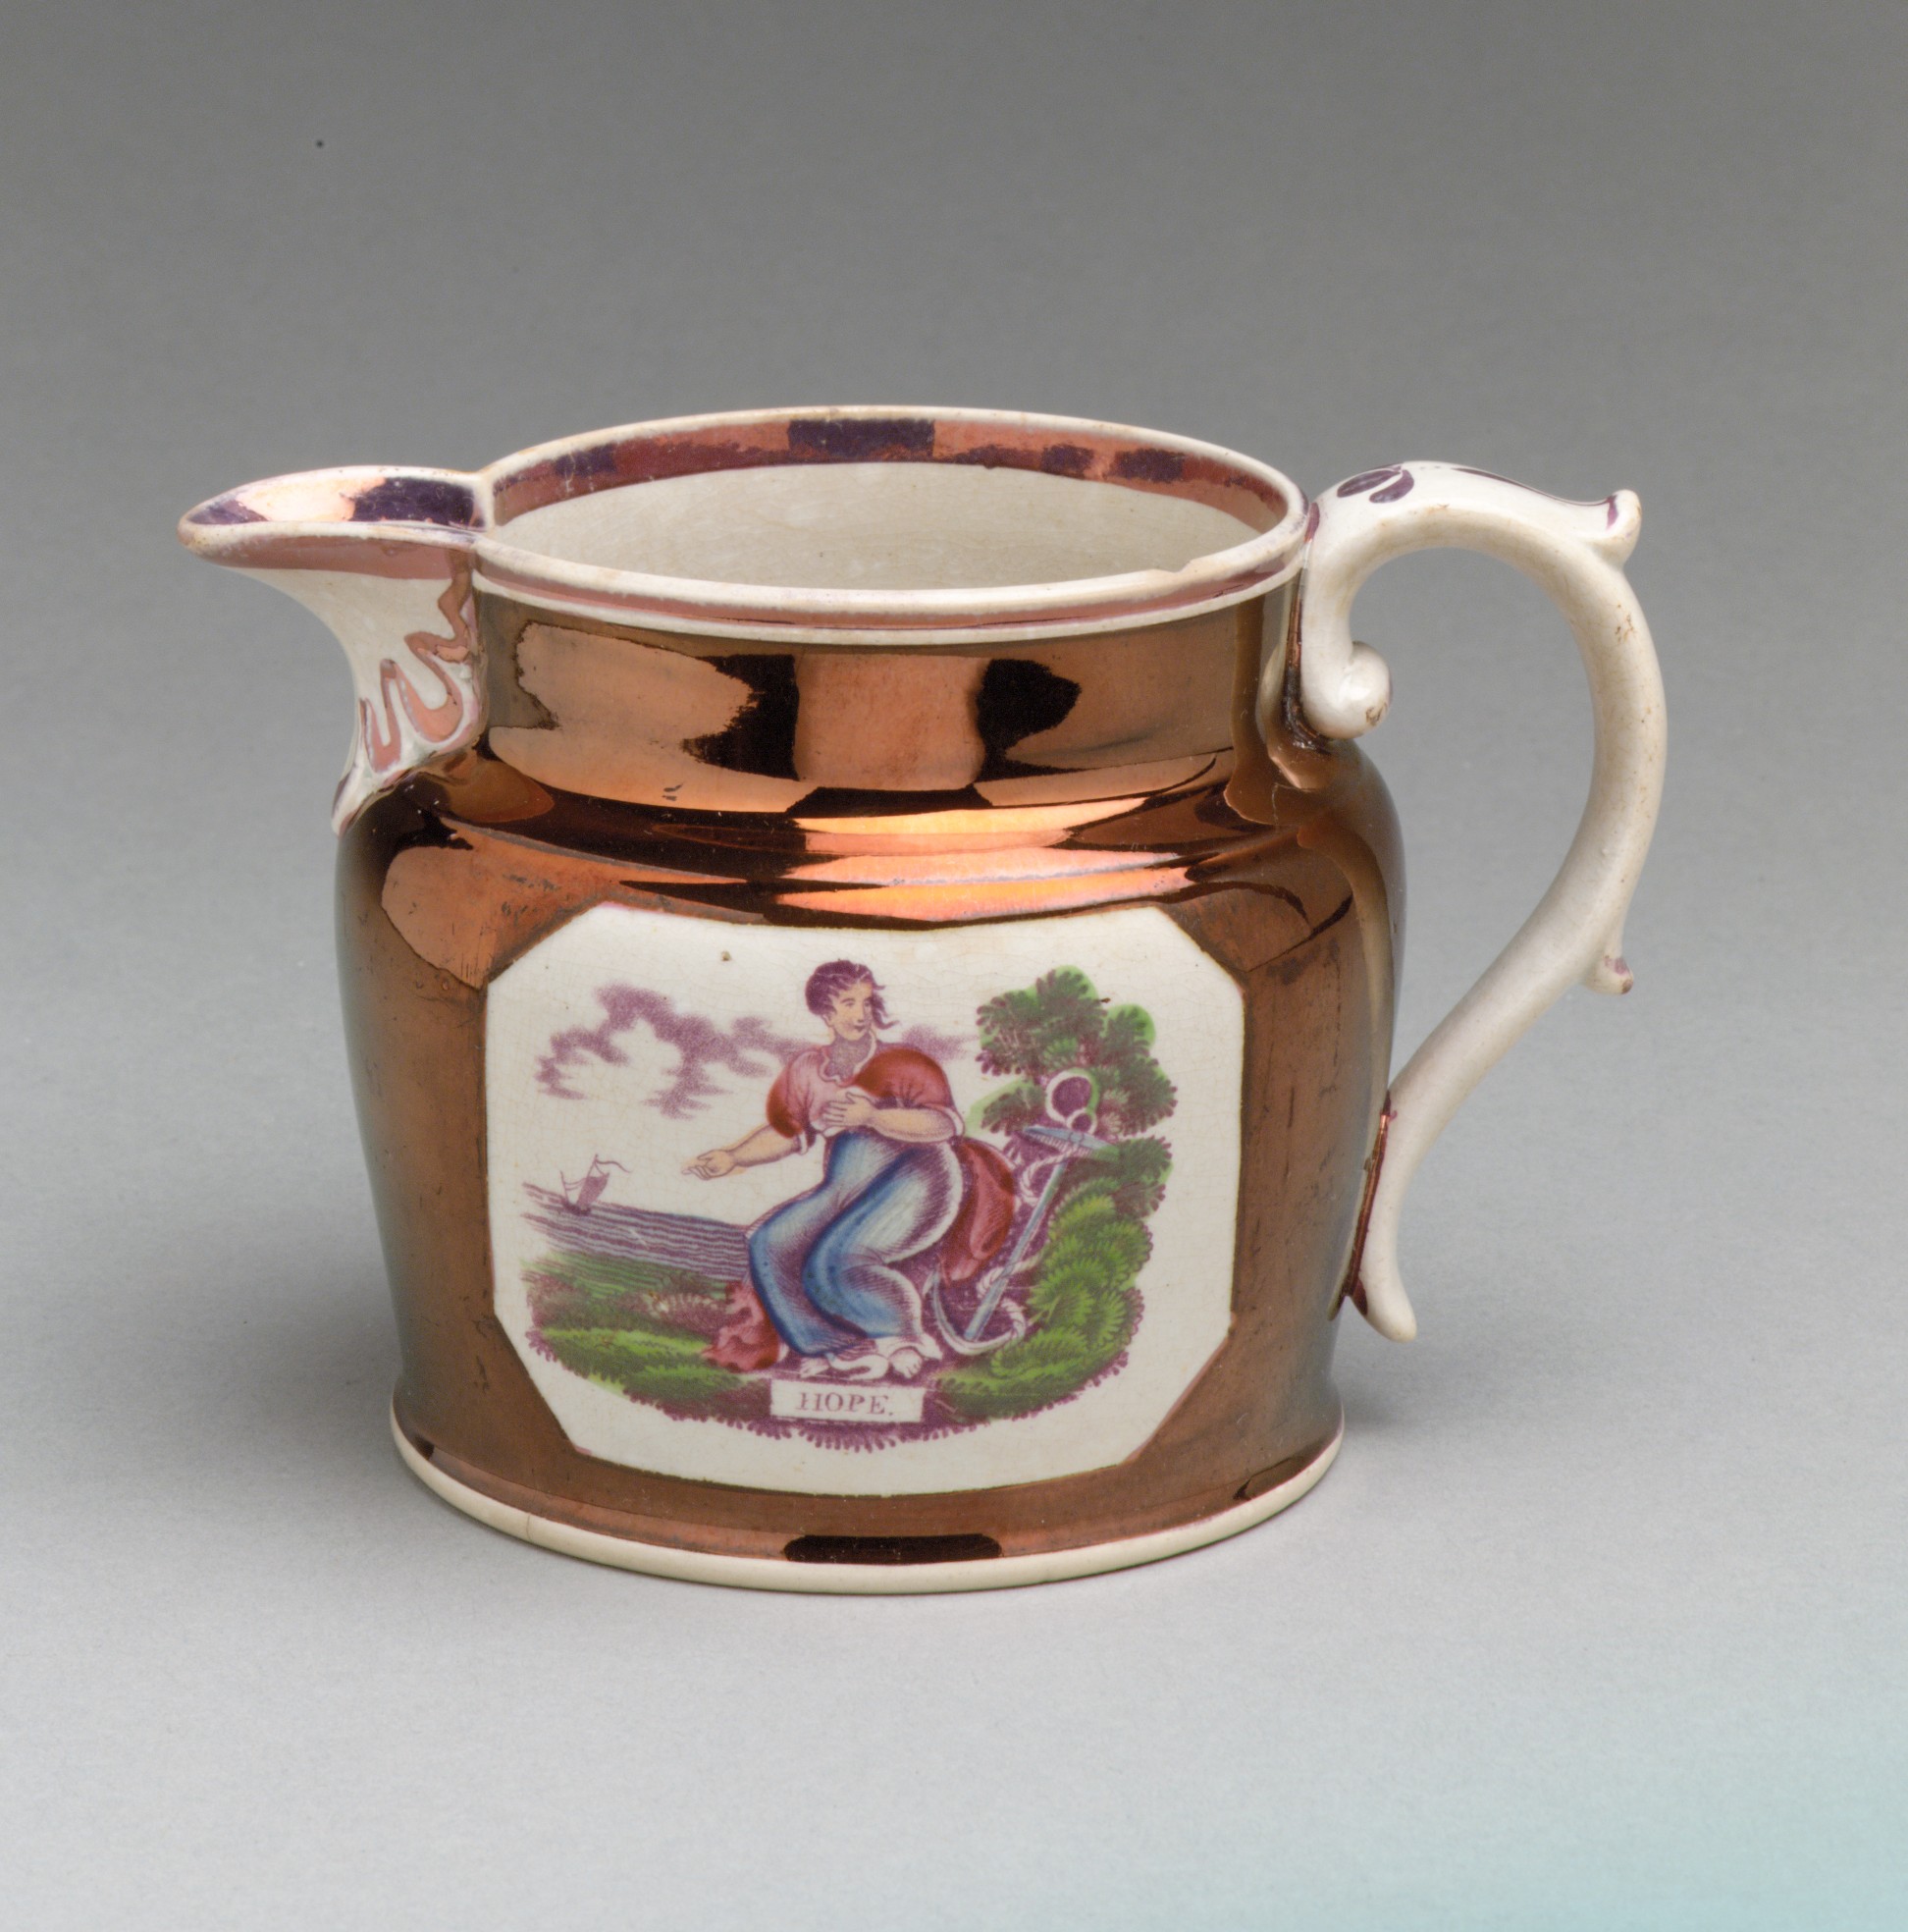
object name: pitcher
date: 1801-1900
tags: women